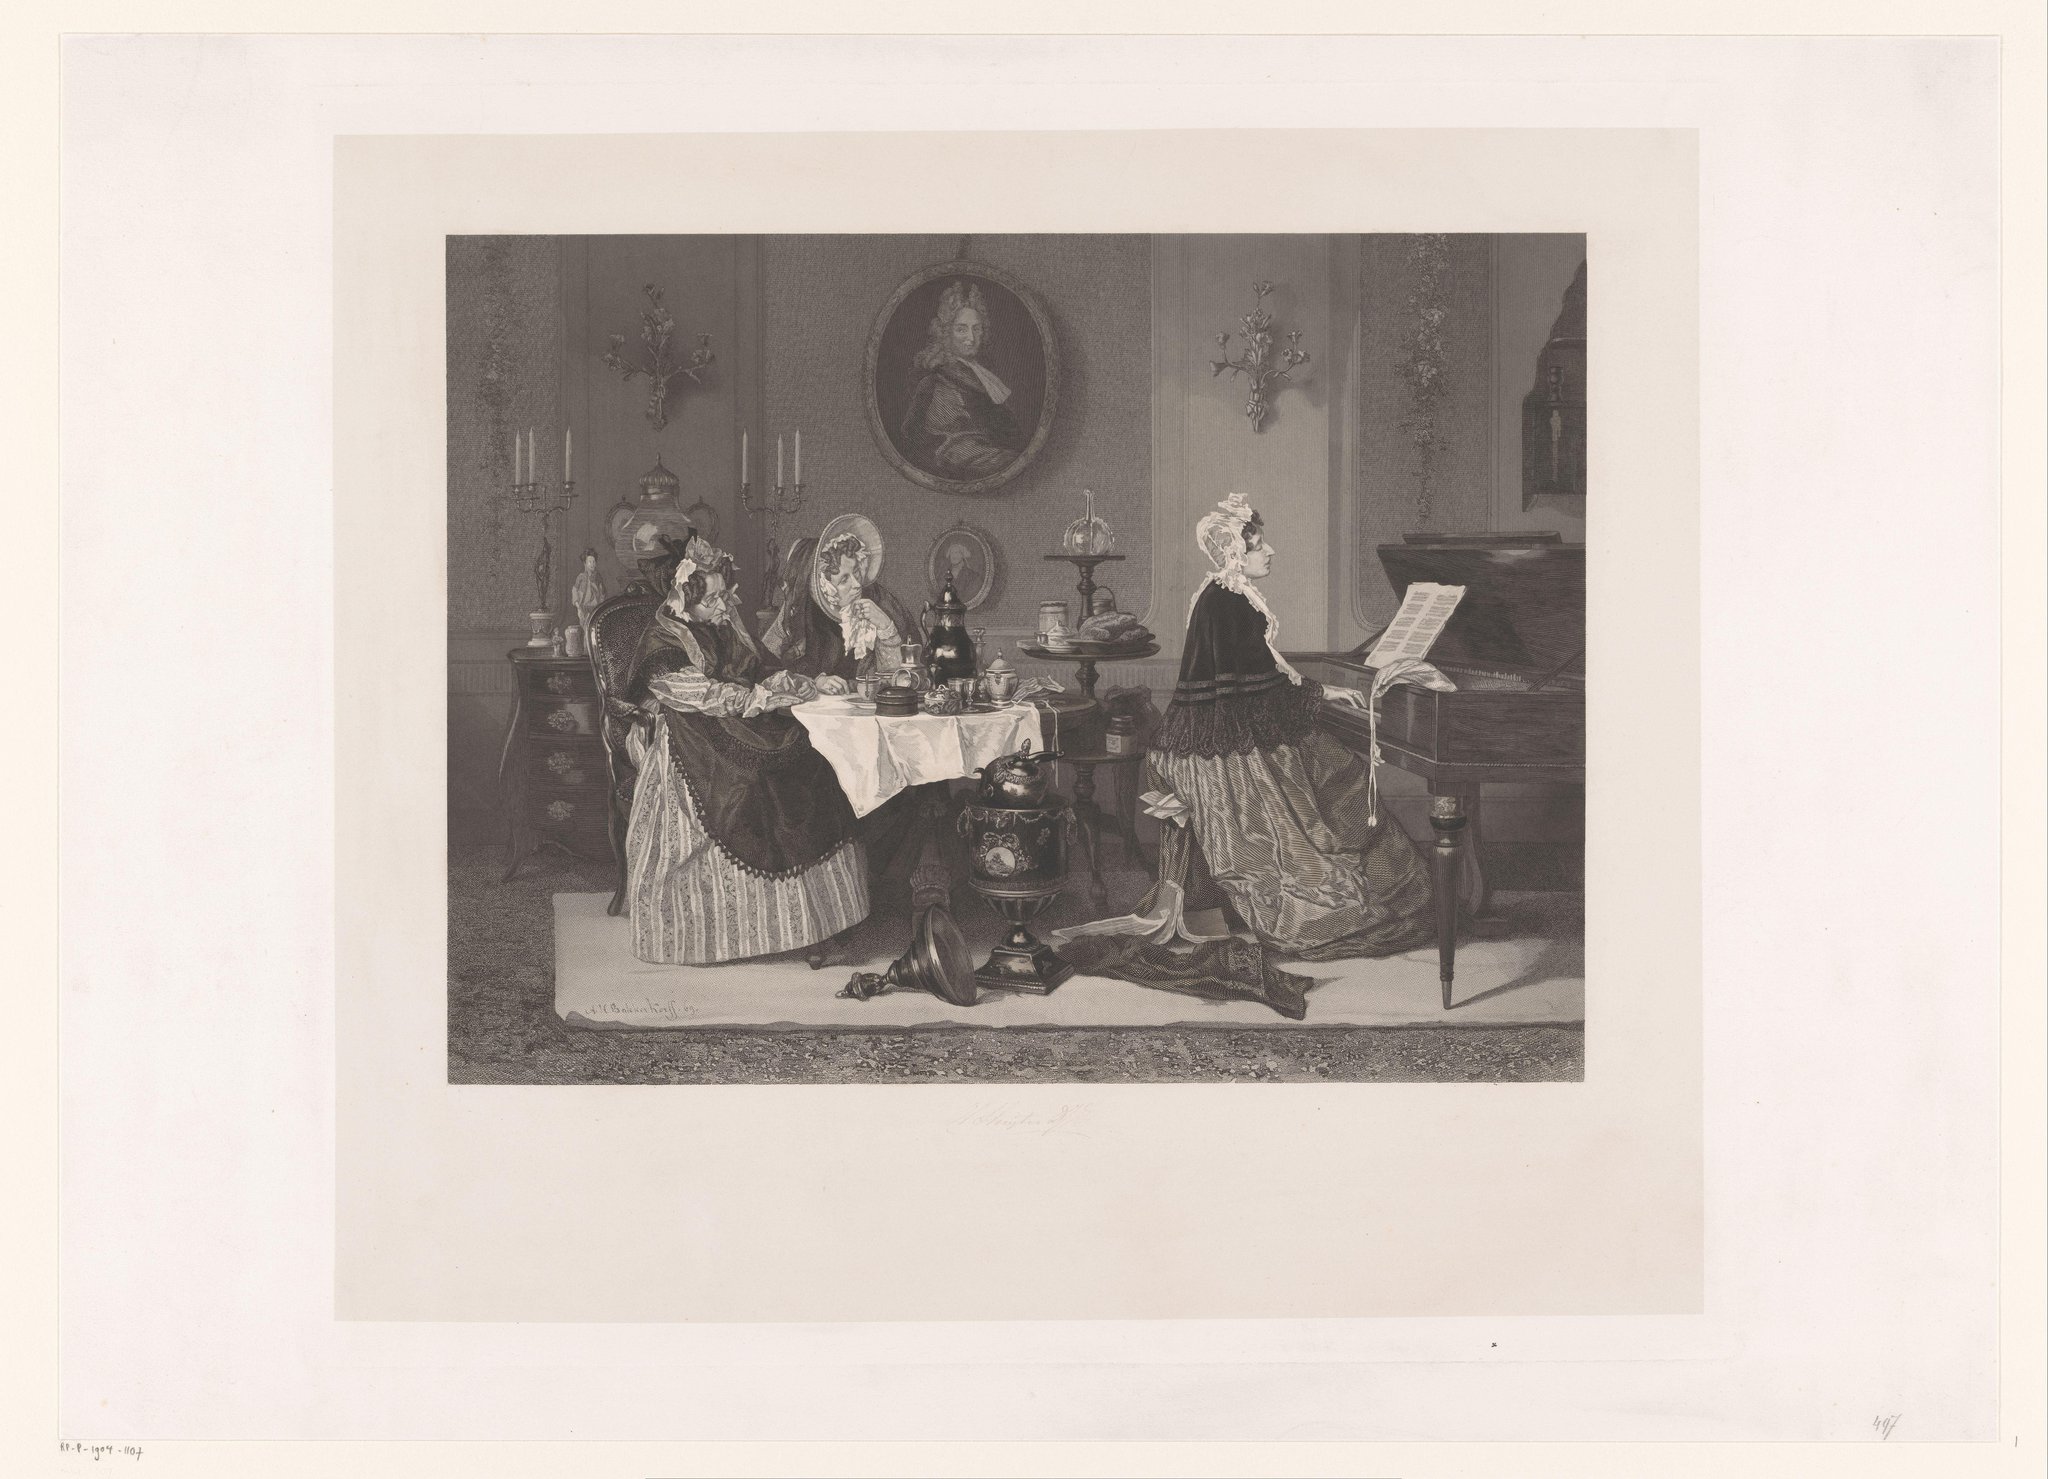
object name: print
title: Twee vrouwen luisteren naar het pianospel van een jonge vrouw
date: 1869-1872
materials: paper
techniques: engraving, etching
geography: amsterdam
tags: grand piano, interior of the house, tea-ceremony, afternoon tea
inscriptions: collector's mark: Lugt 2228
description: In een interieur luisteren twee oudere dames , bij een tafel met een theeservies, naar het pianospel van een derde, jongere vrouw.